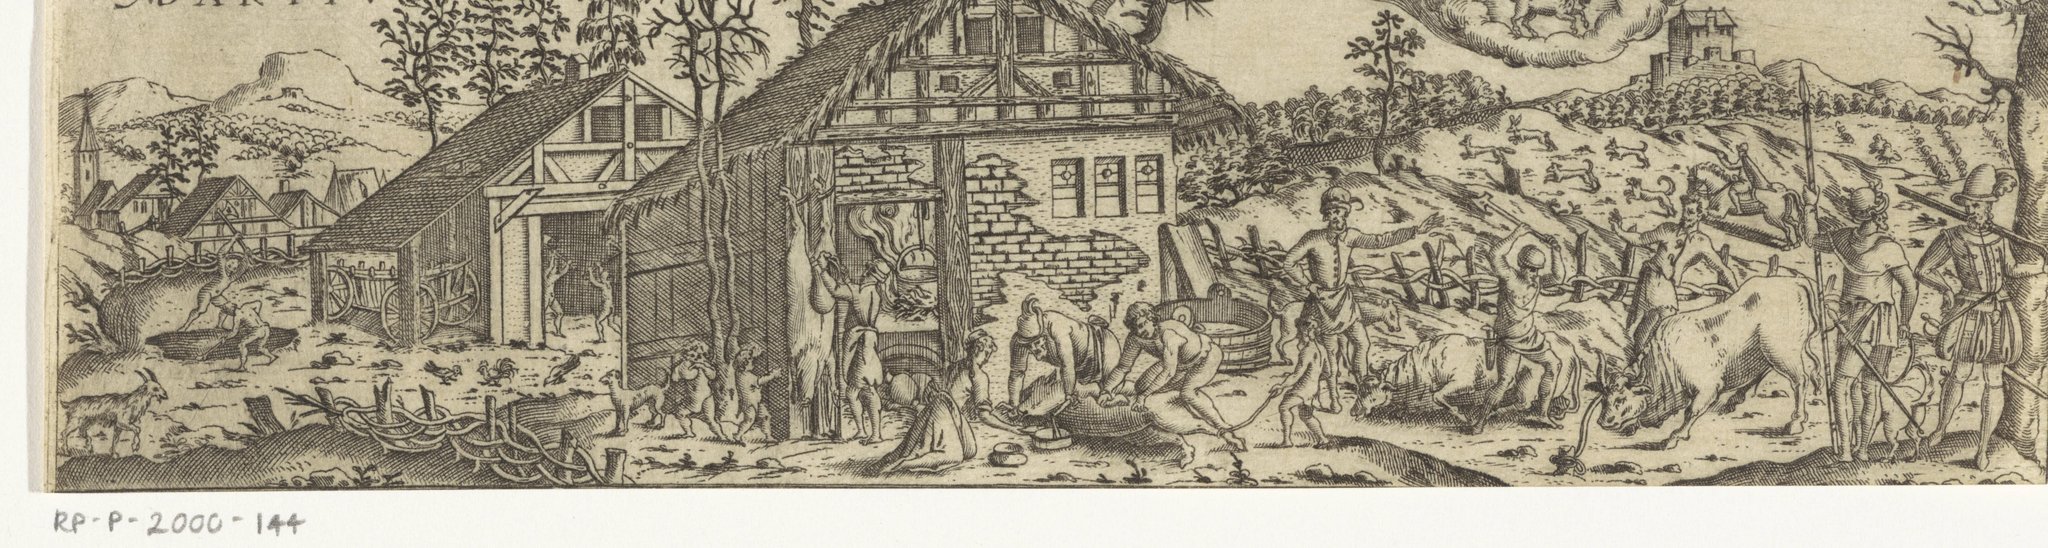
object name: print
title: Martius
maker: Anonymous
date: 1554-1641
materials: paper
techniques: etching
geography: netherlands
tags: slaughtered ox or pig, march and its 'labours' (+ with zodiacal signs)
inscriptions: collector's mark: Lugt 2760, collector's mark: Lugt 2228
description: Werkzaamheden van de maand maart. Vooraan worden de (paas)ossen geslacht. Rechtsachter een jachtpartij. Rechtsboven in de lucht het dierenriemteken Ram.